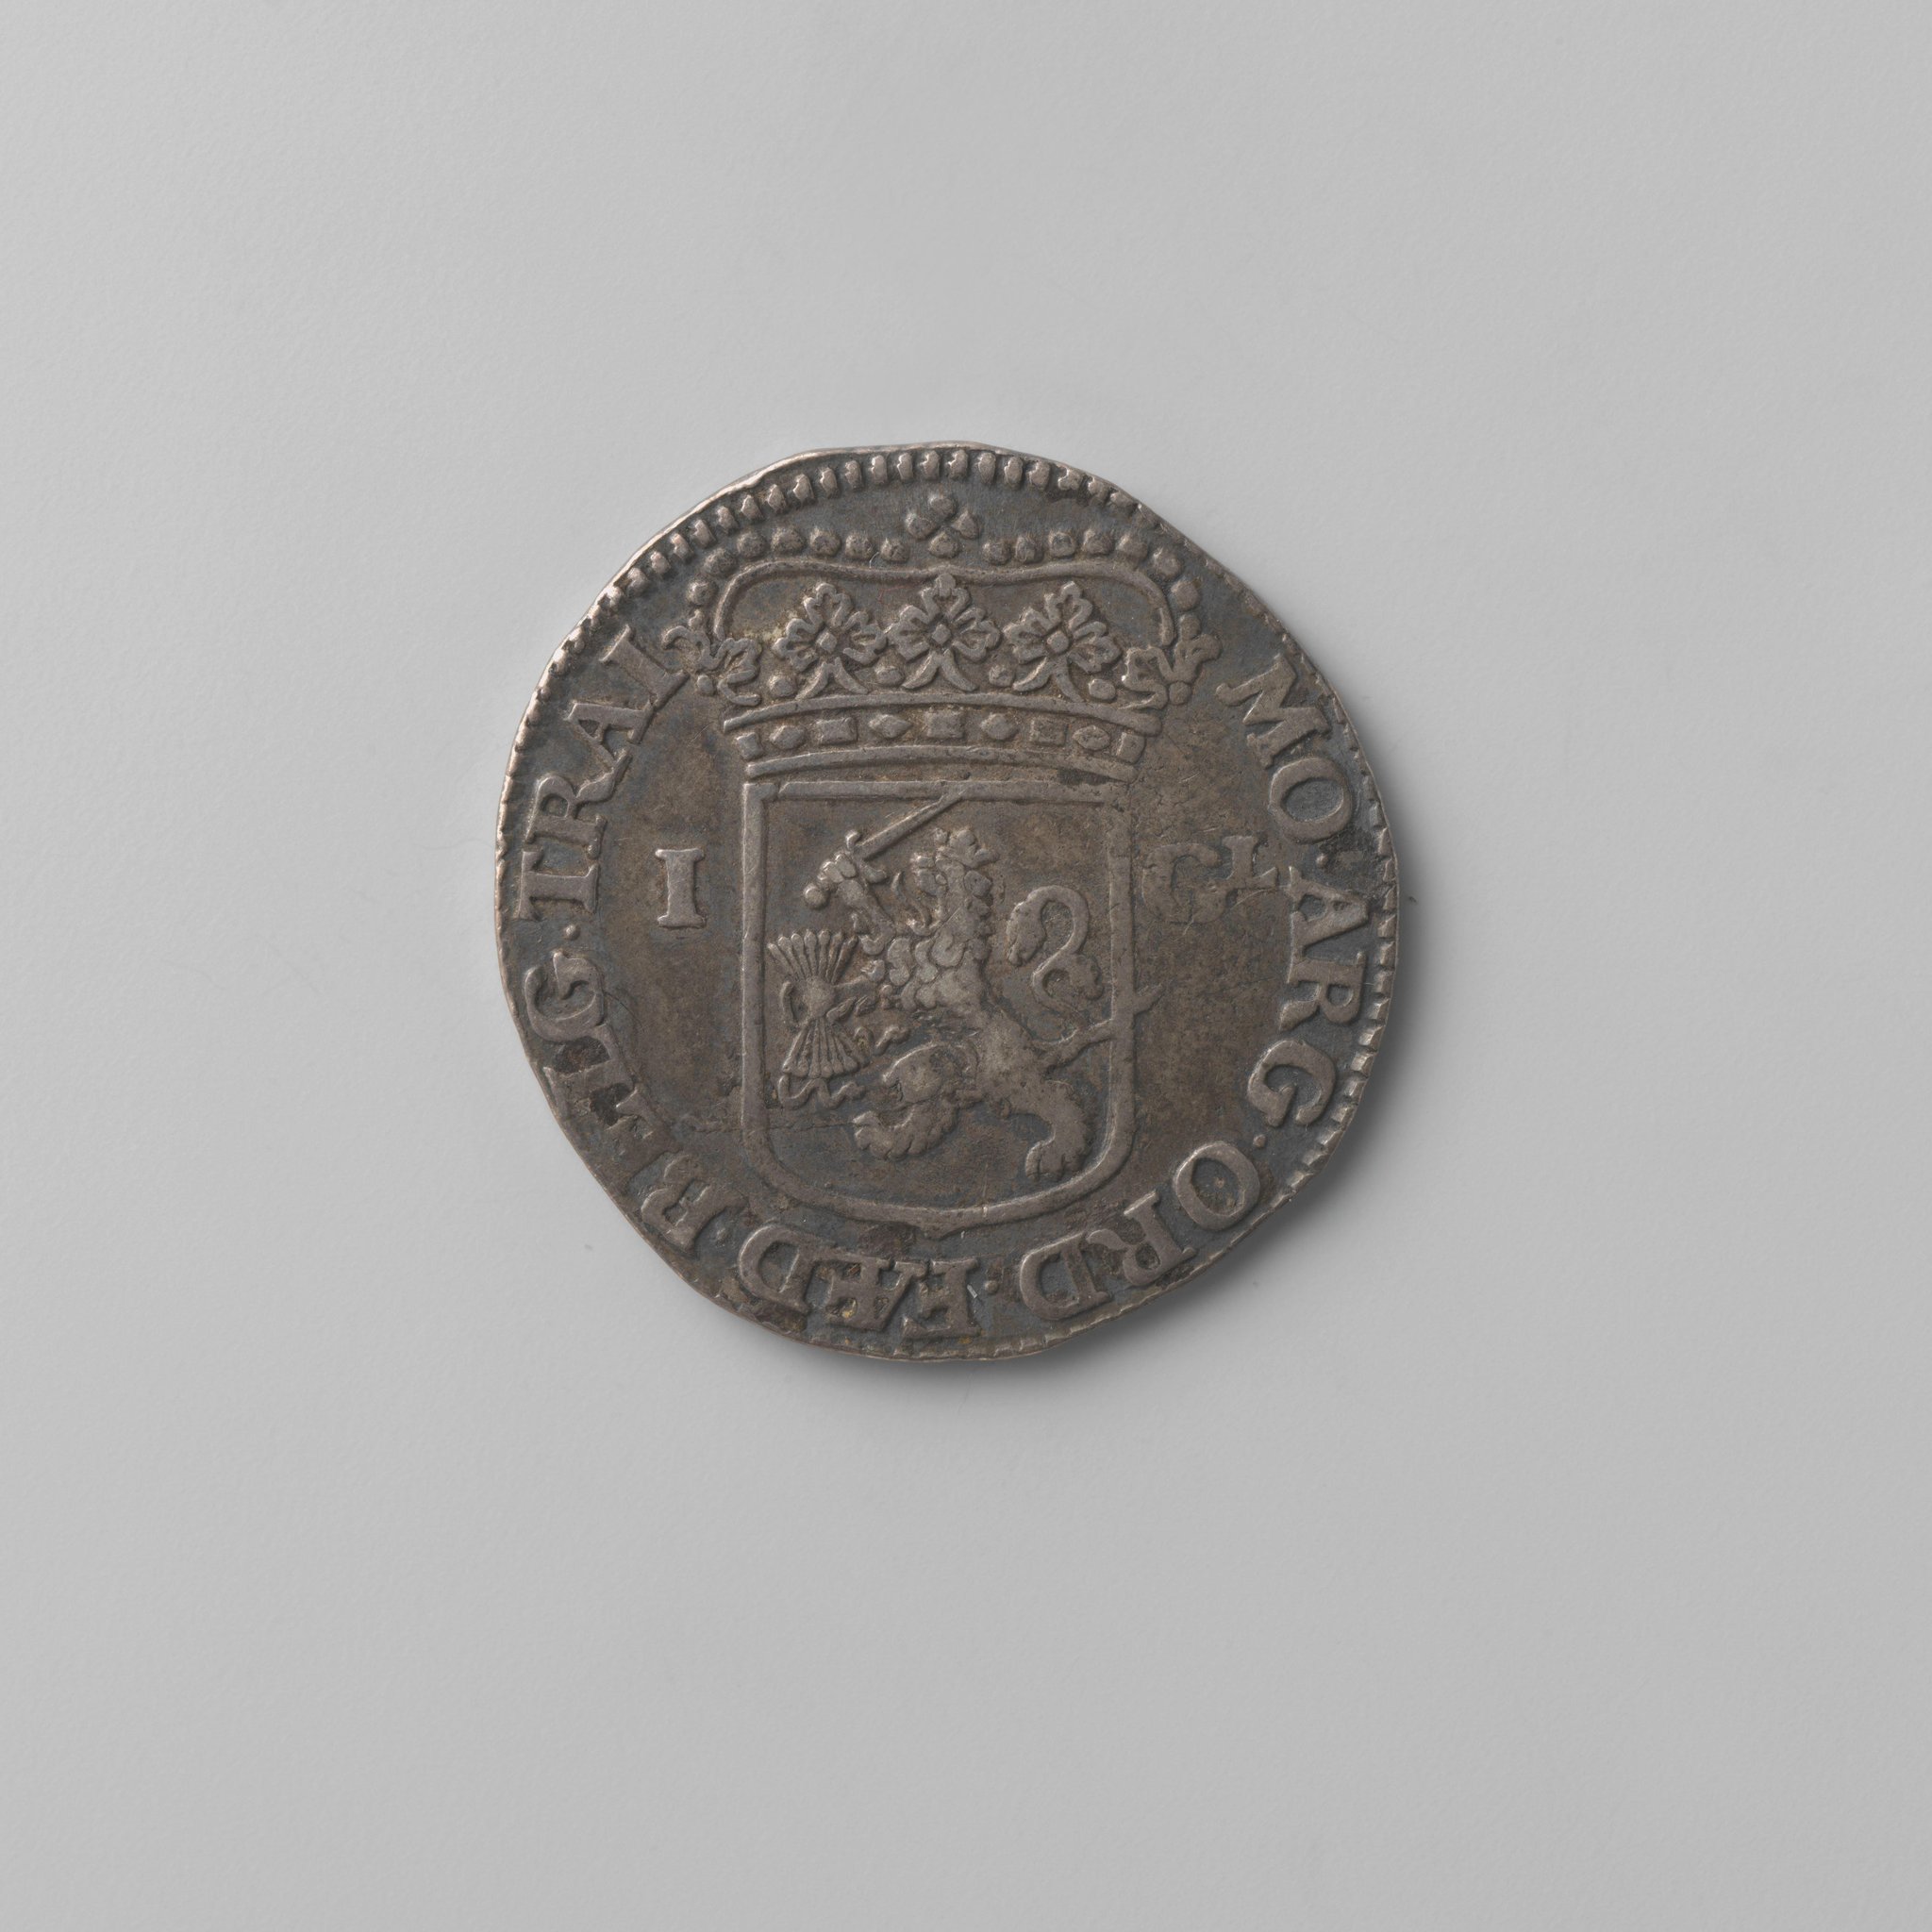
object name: coin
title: Utrecht, gulden, 1712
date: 1712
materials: silver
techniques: striking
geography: utrecht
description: Zilveren munt. Voorzijde: tussen waarde-aanduiding gekroond generaliteirtswapenschild. Keerzijde: Nederlandse maagd met vrijheidshoed en speer, leunend op een bijbel op een altaar. In afsnede jaartal.